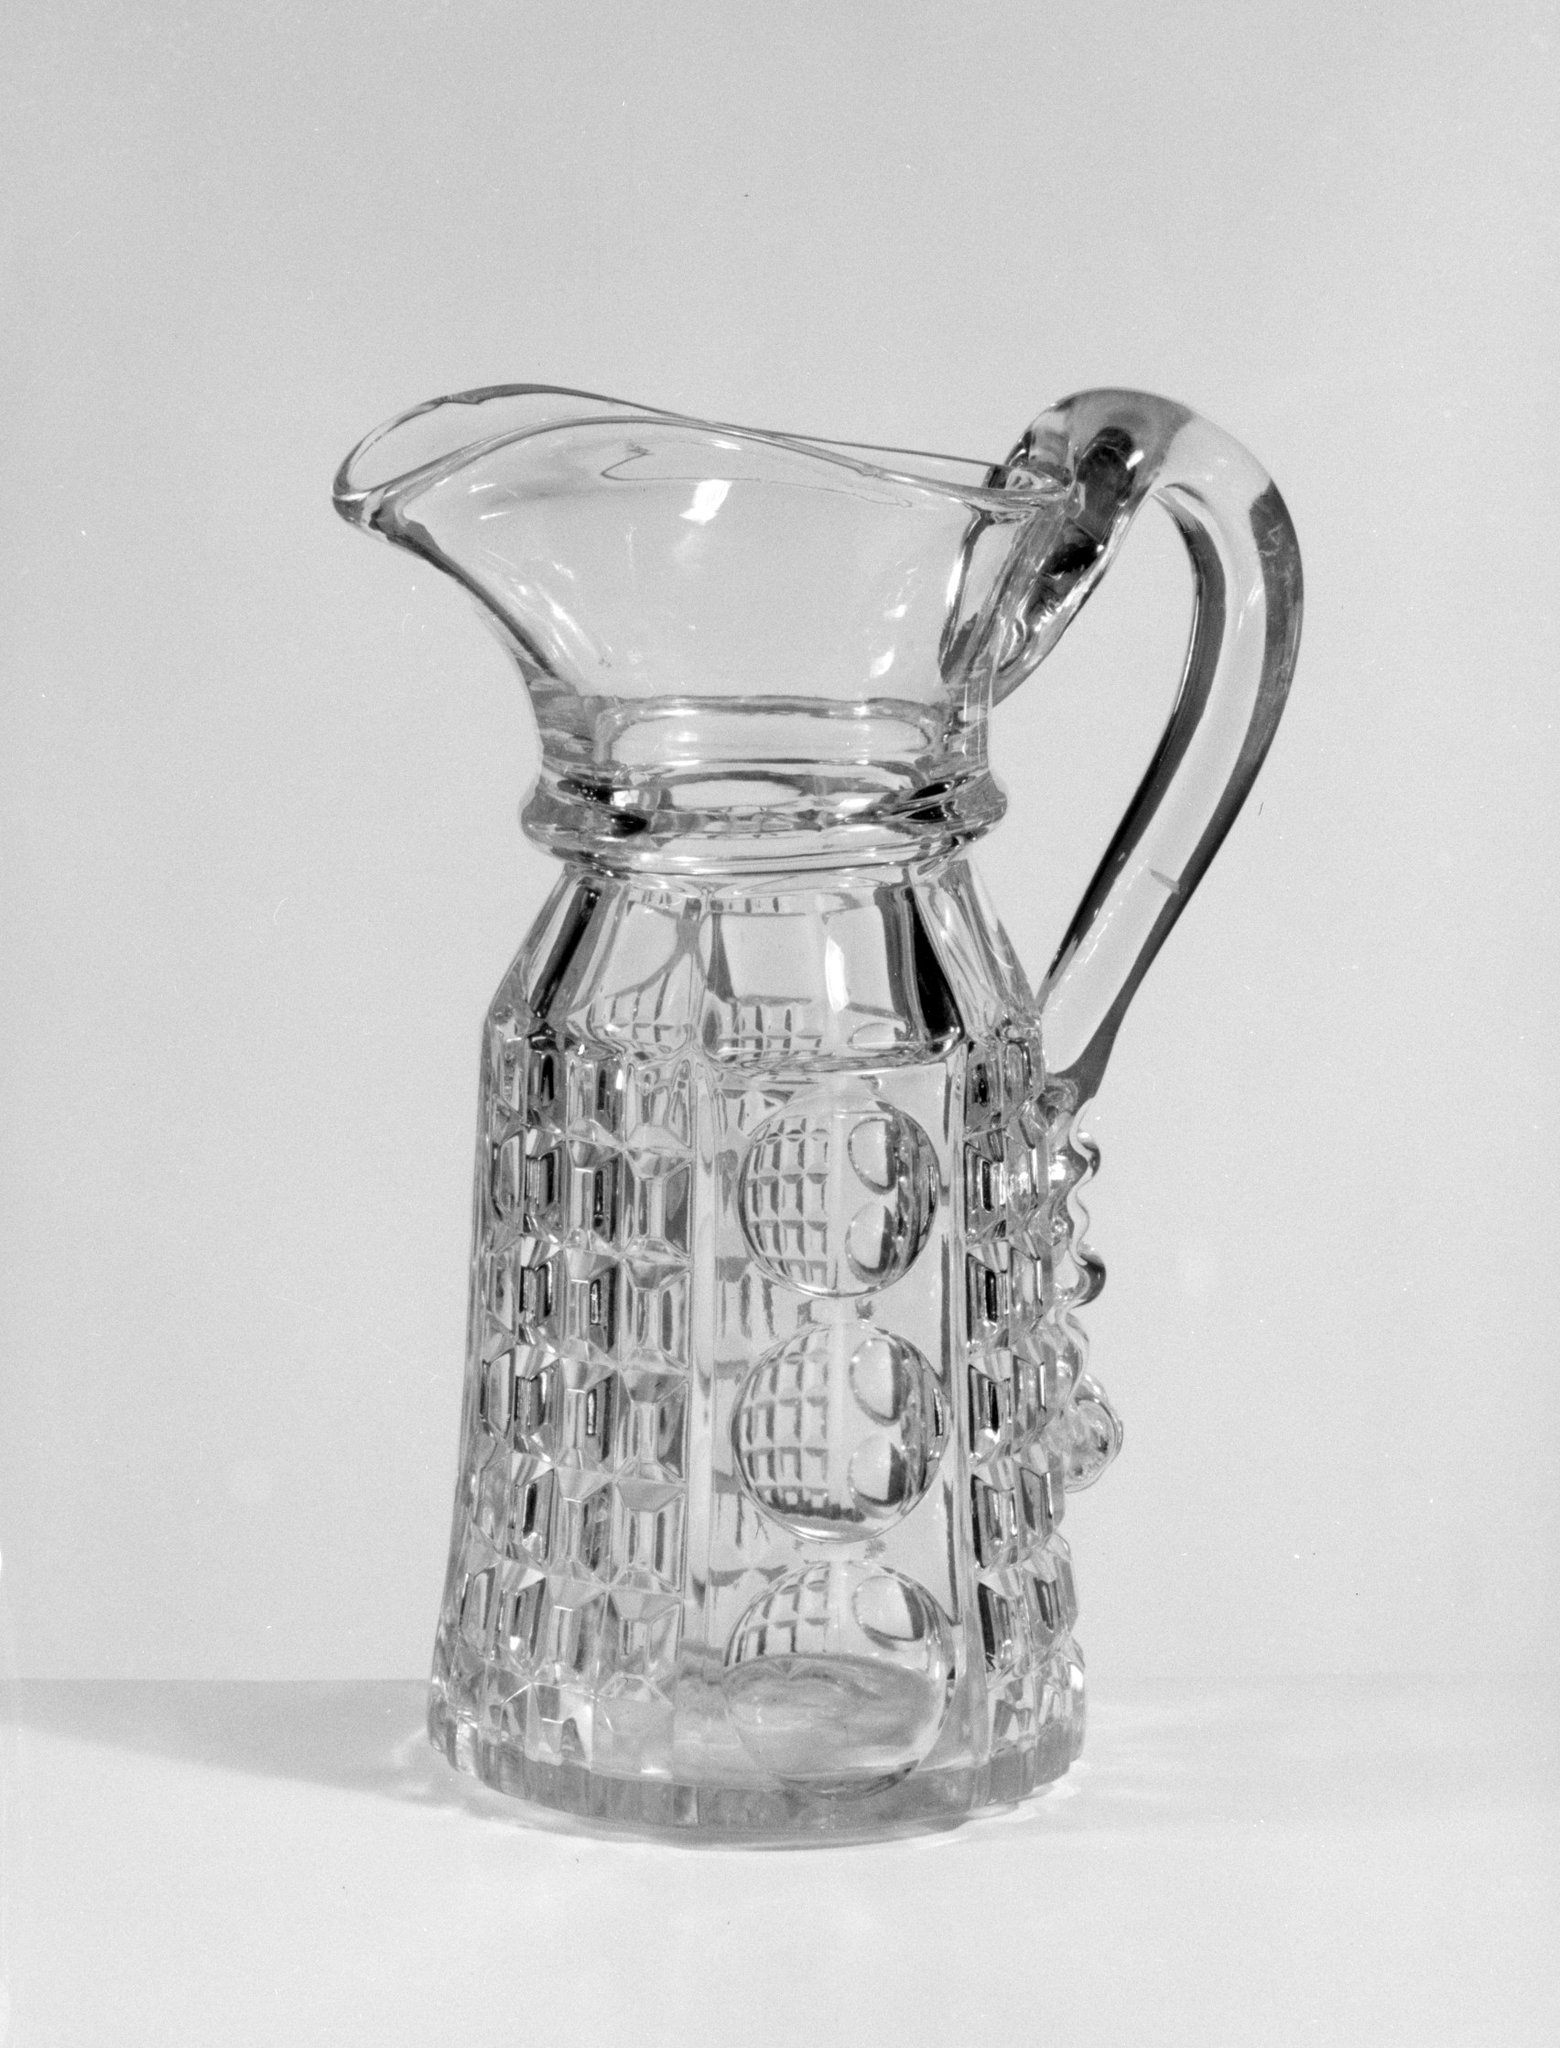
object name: pitcher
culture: american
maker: new england glass company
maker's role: maker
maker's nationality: american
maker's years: 1818-1888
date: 1800-1900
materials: glass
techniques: pressed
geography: united states